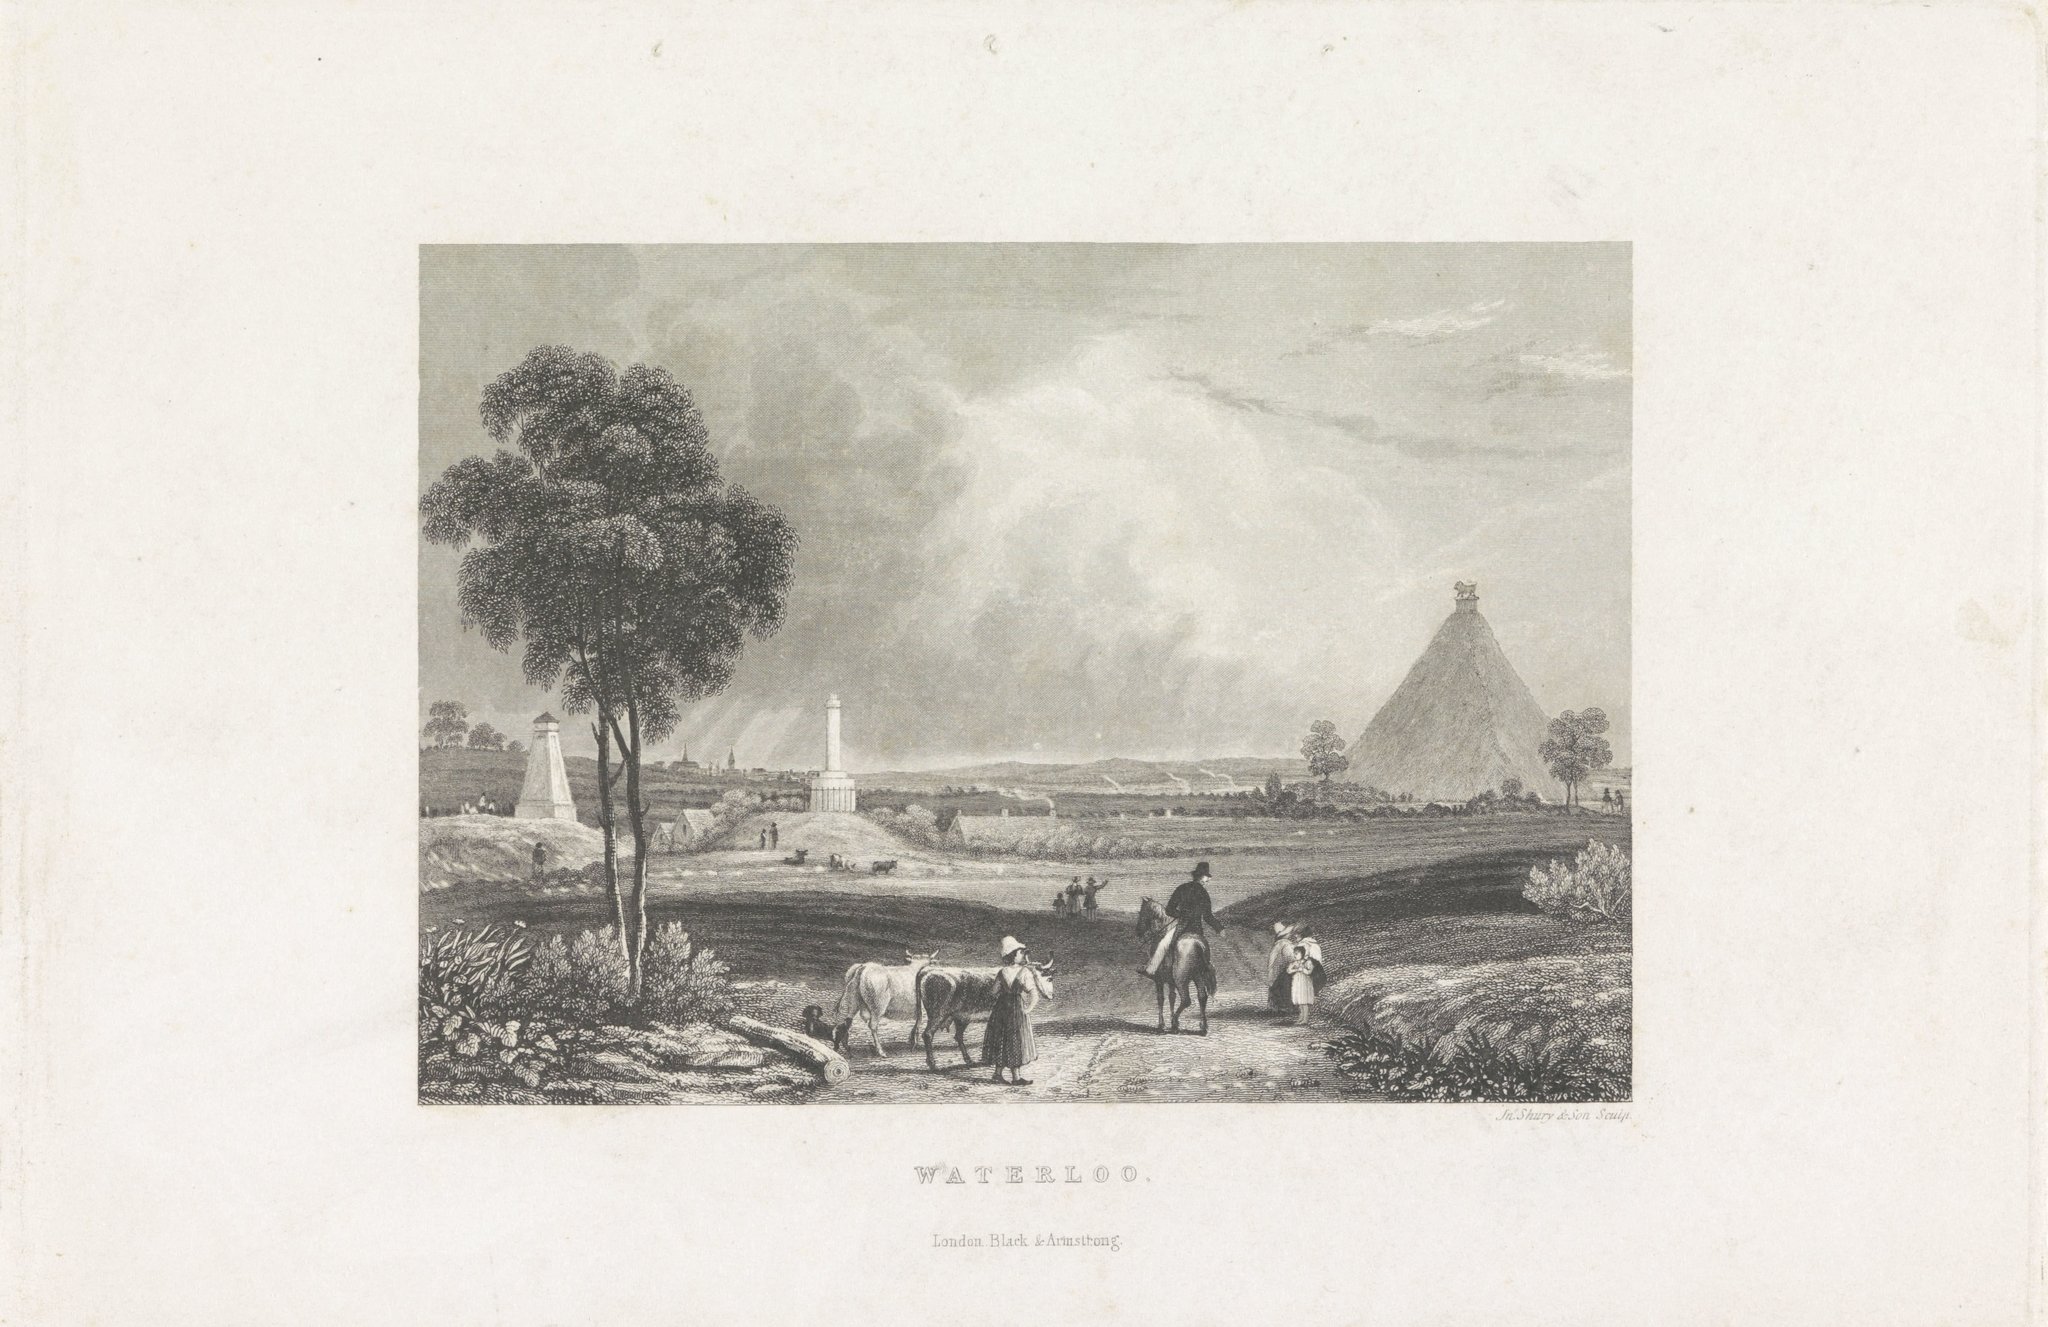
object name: print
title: Waterloo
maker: john shury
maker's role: print maker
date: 1814-1844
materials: paper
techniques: engraving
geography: england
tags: landscape with monument, waterloo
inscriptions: collector's mark: Lugt 2228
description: Gezicht op het slagveld van Waterloo met de verschillende monumenten. Op de voorgrond een ruiter en een veehoedster.